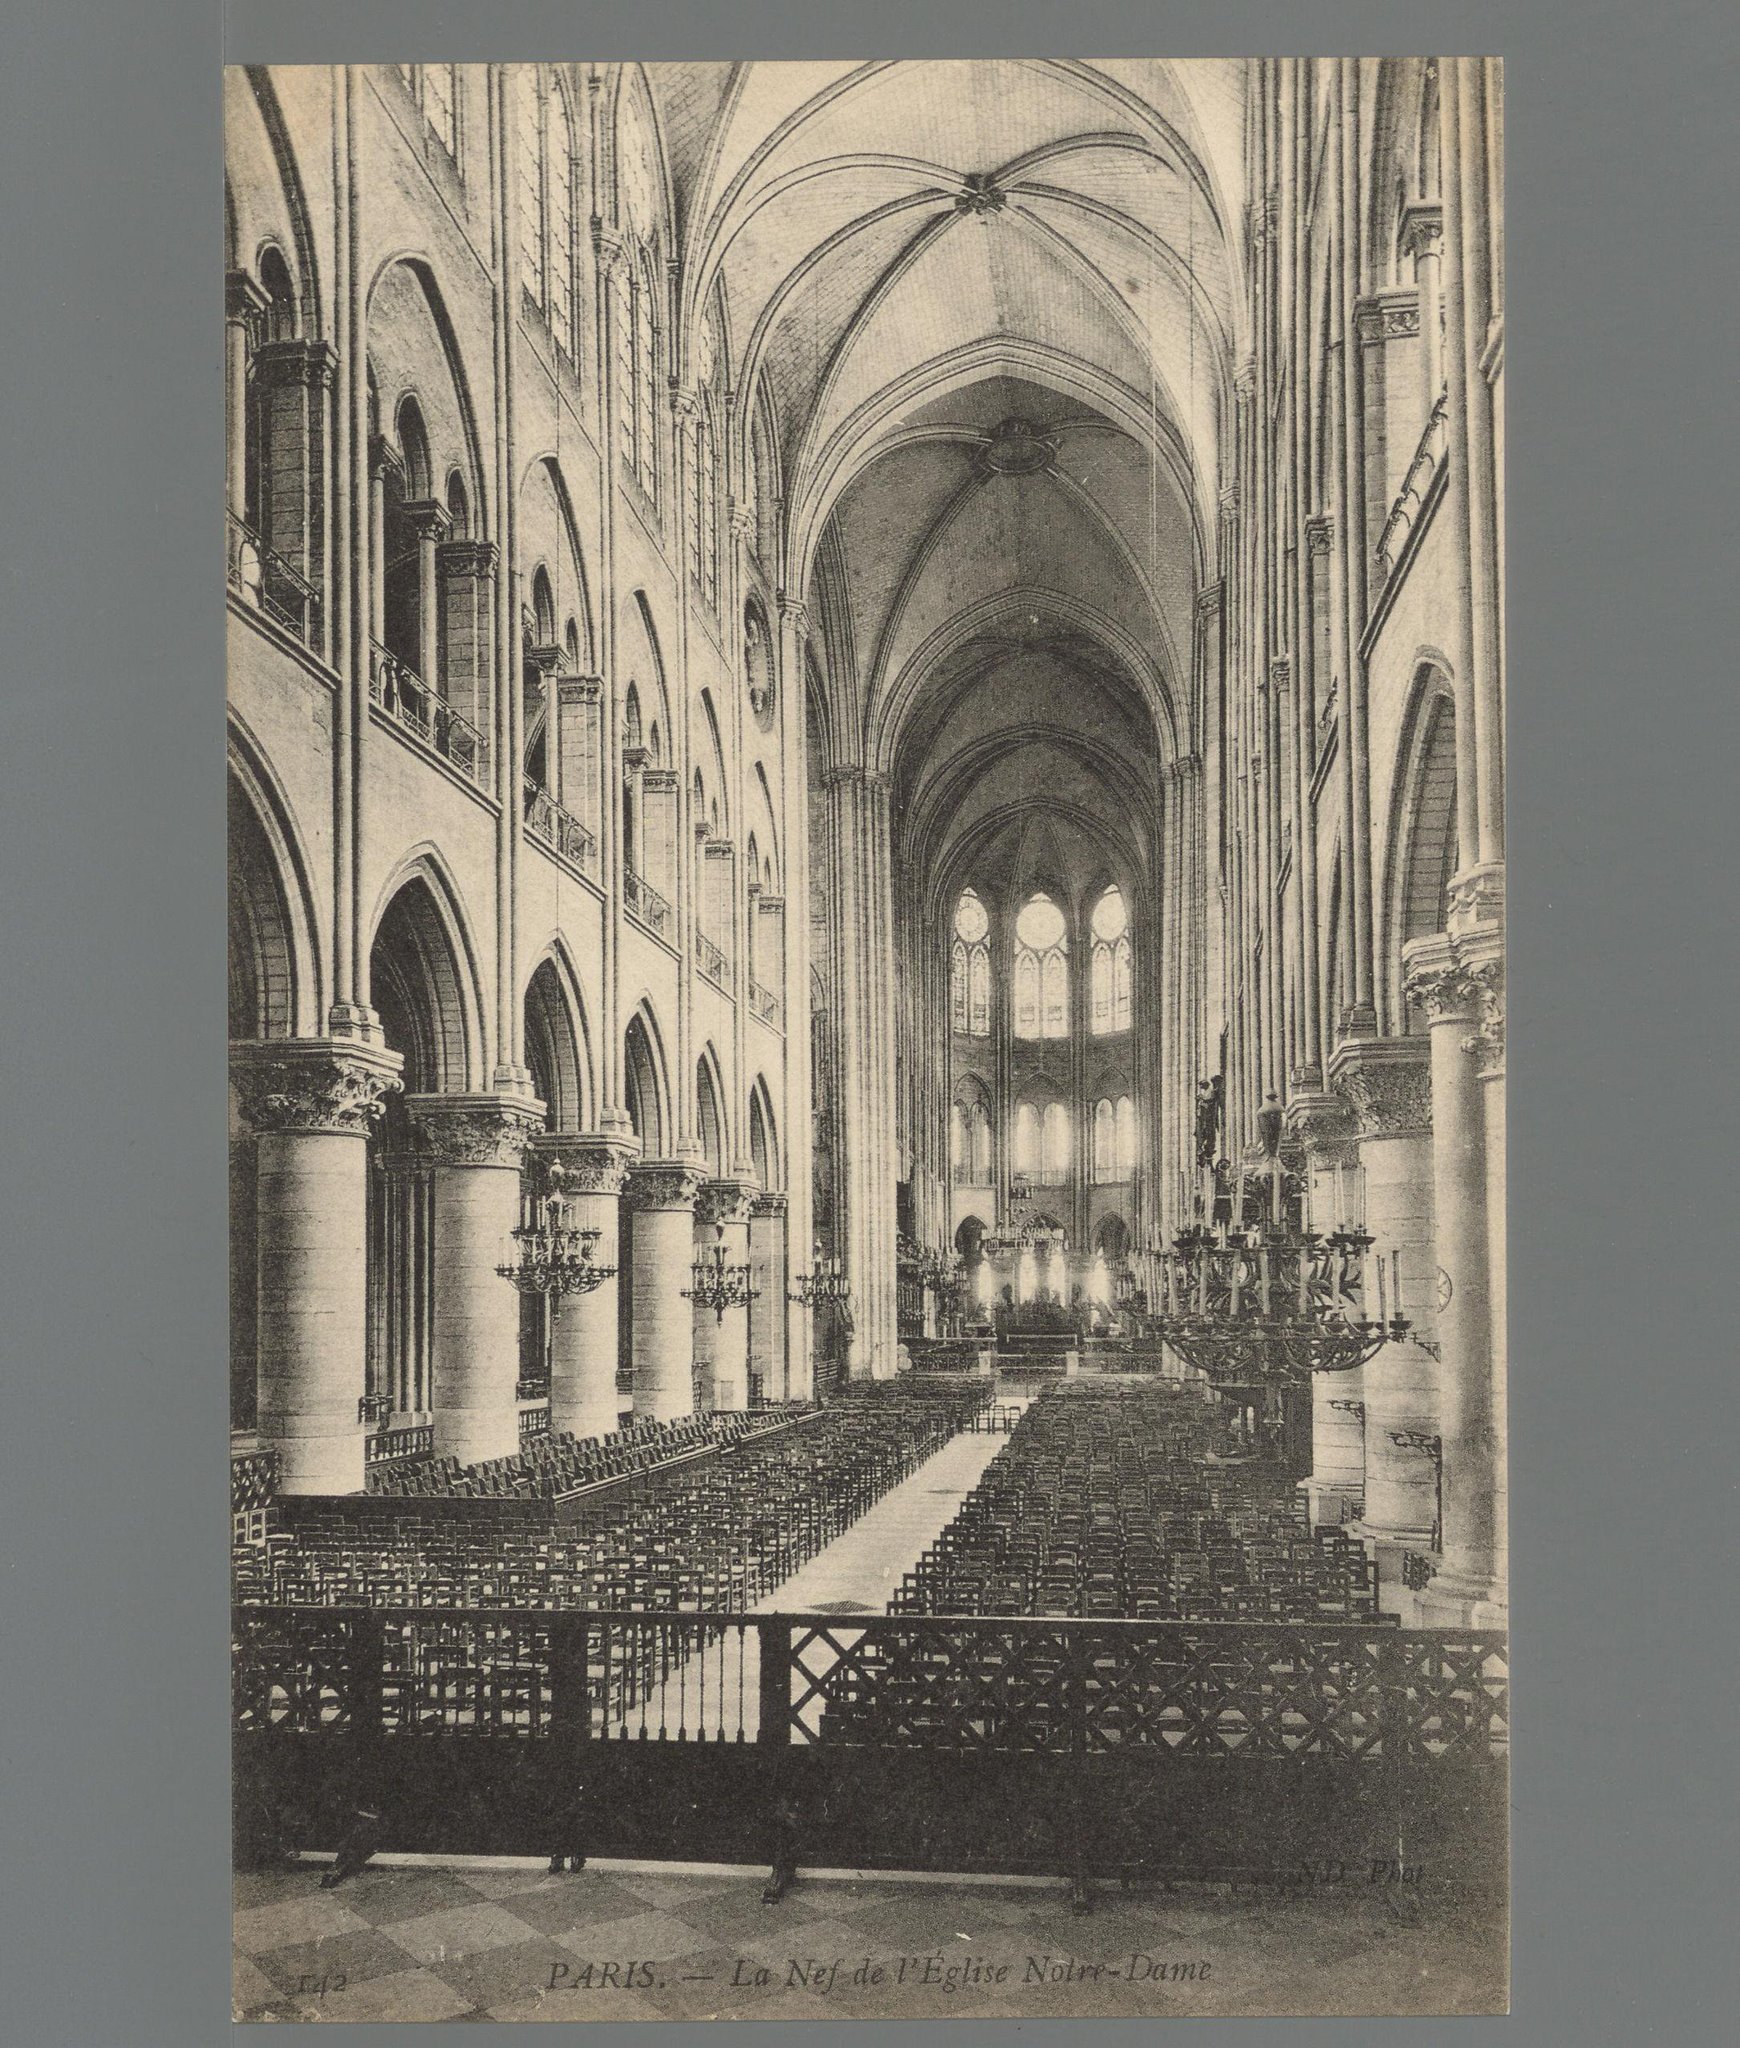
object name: photomechanical print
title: Paris. La Nef de l'Église Notre-Dame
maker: Anonymous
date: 1904-1906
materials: cardboard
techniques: photograph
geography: paris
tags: parts of church interior: nave